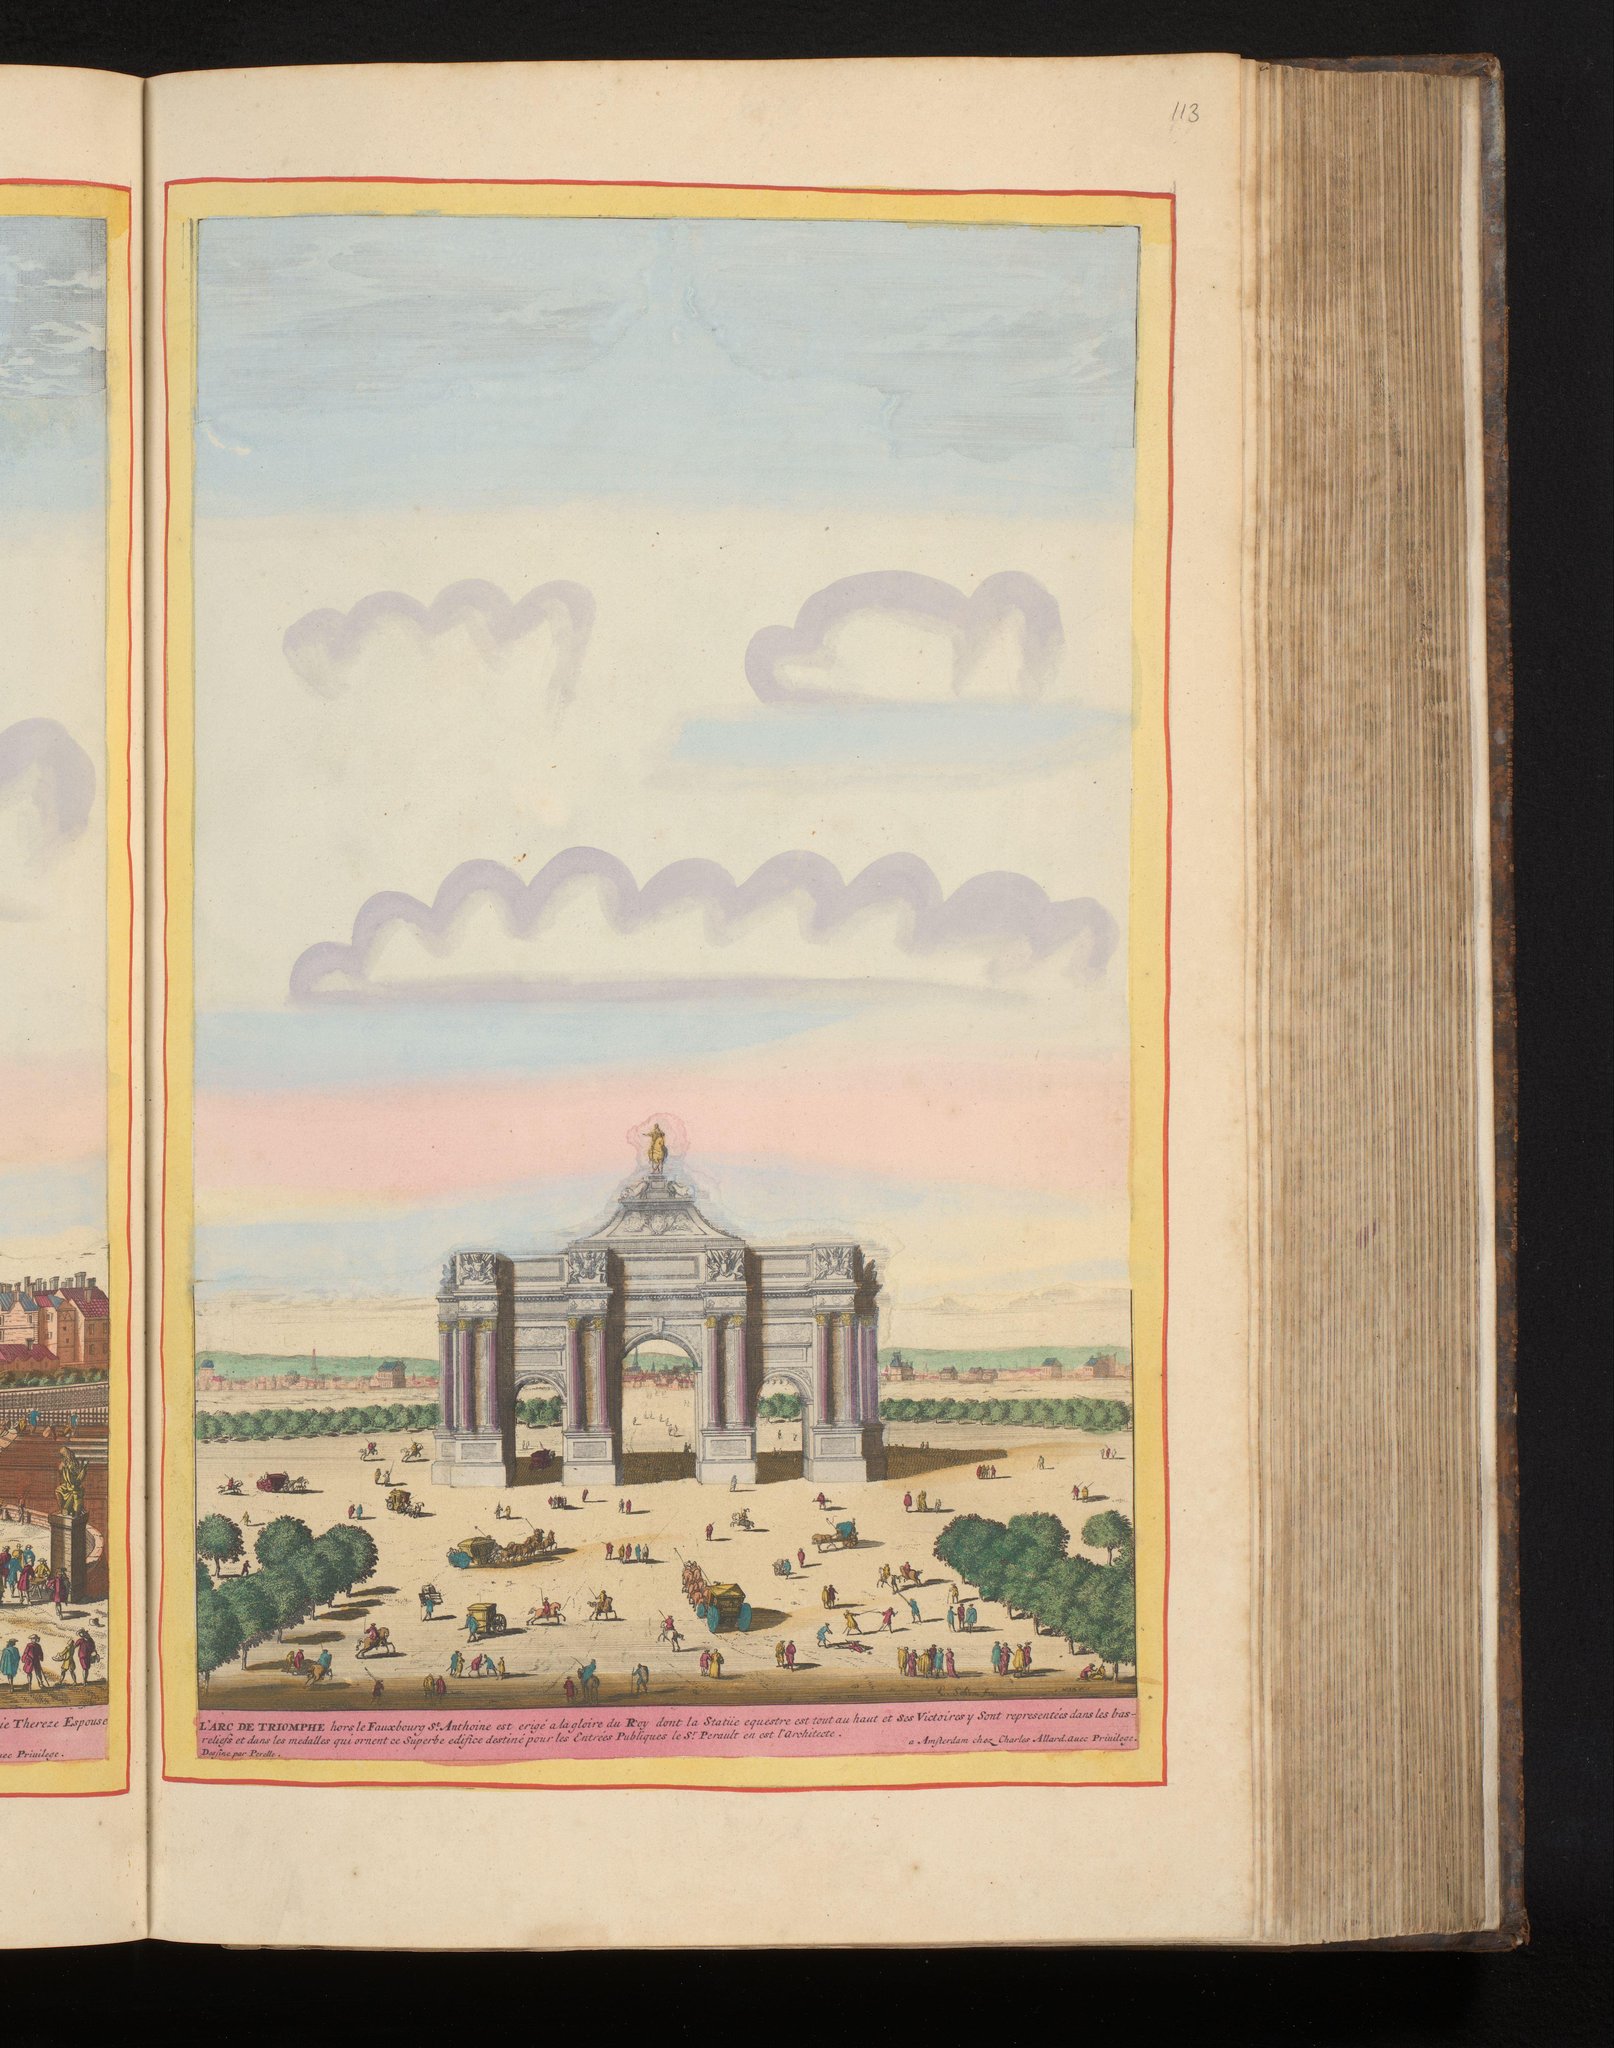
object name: album leaf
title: L'Arc de Triomphe (...)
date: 1689-1701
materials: paper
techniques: etching, hand coloring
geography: paris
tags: triumphal arch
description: De prent is langs de bovenrand van de voorstelling afgescheurd. Het bovenste gedeelte is hoger opgeplakt, zodat de lucht hoger is geworden en het formaat van de voorstelling past bij de andere groot formaatvoorstellingen in het album.